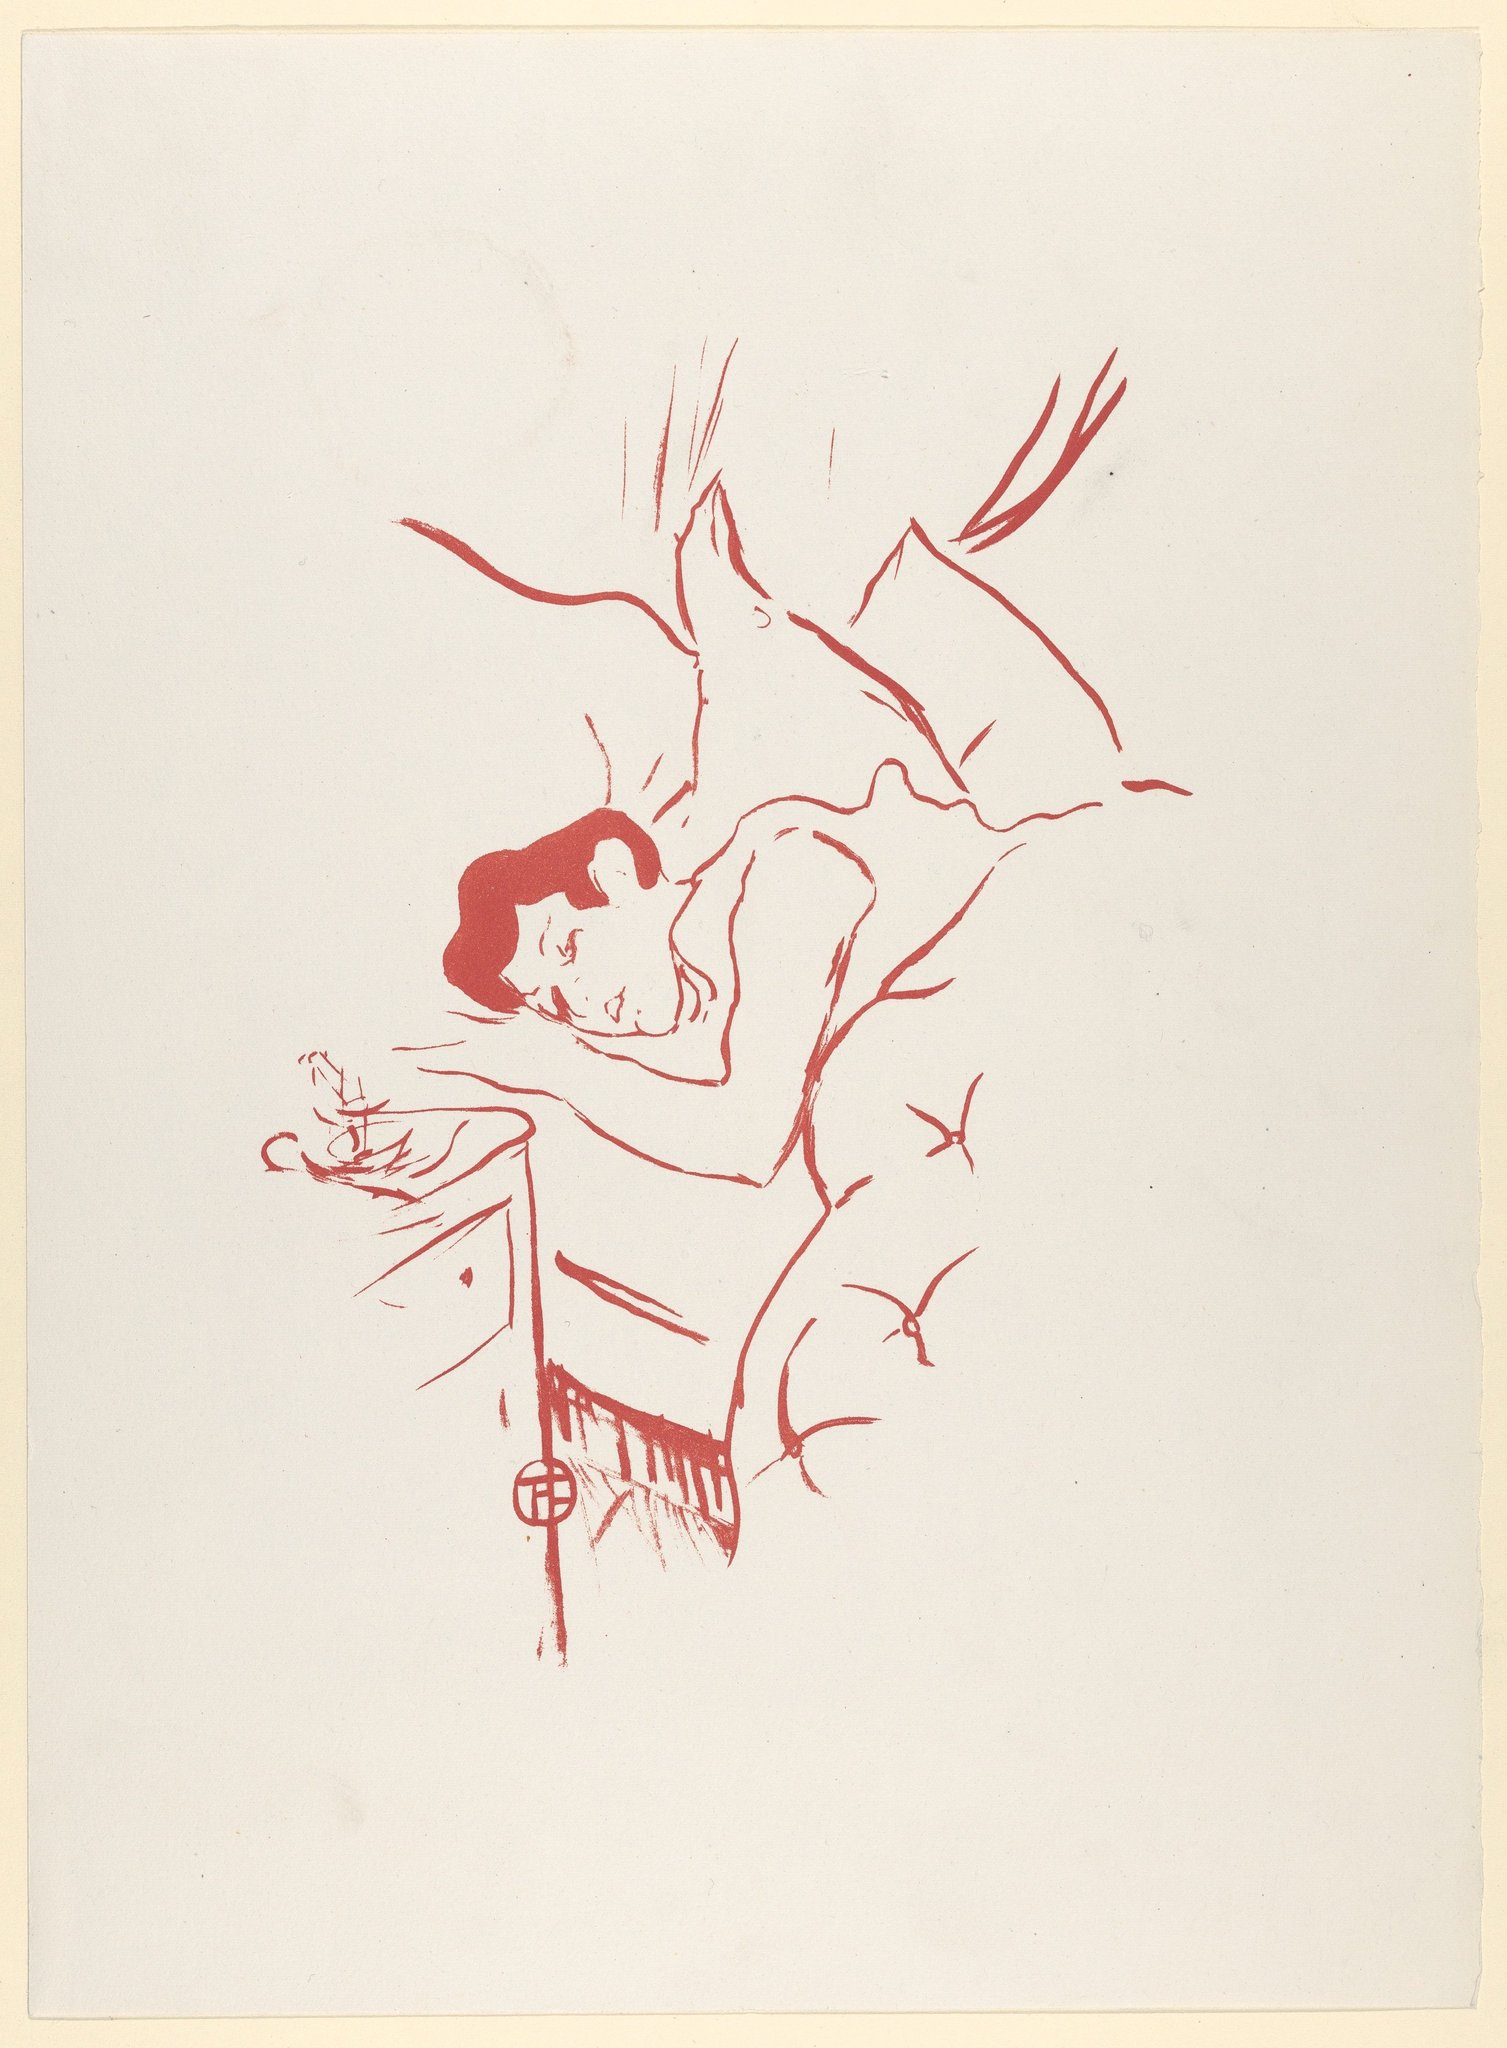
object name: print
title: Your Mouth (from Les Vieilles Histoires)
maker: henri de toulouse-lautrec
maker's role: artist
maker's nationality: french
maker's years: 1864-1901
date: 1893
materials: paper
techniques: lithograph, printing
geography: france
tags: sleeping,women,beds